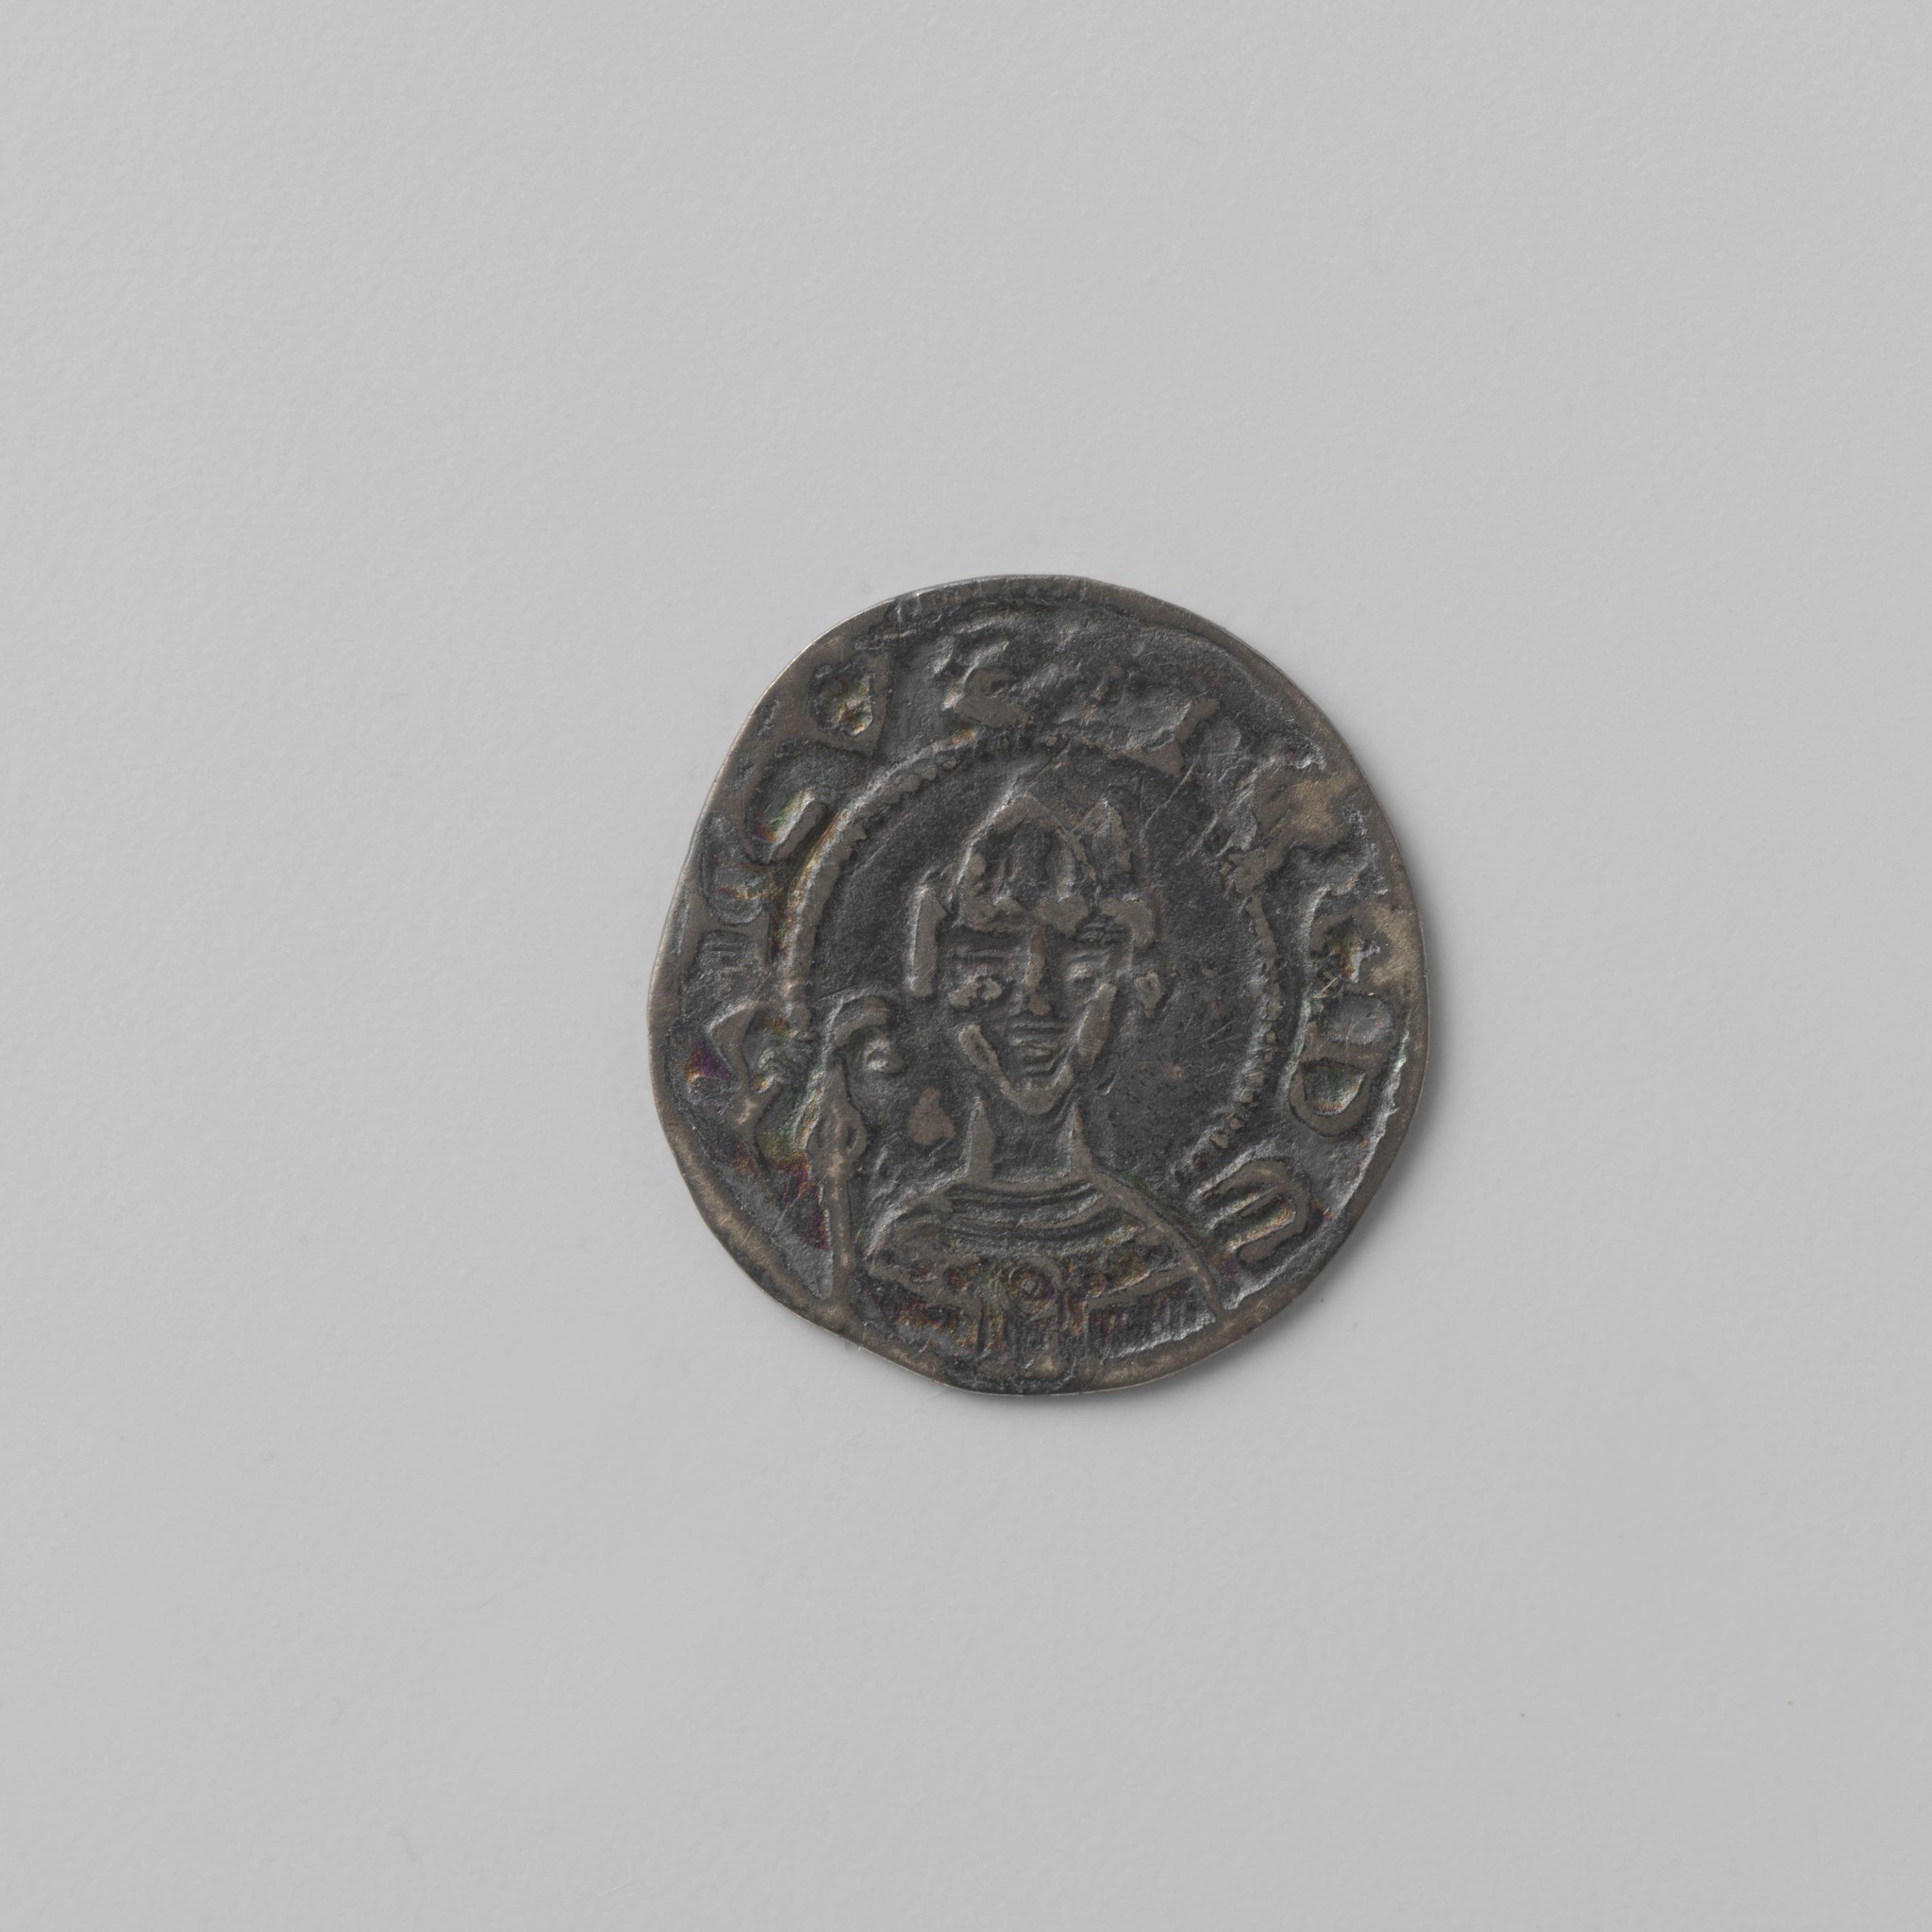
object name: coin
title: Utrecht, Dirk van Ahr, penning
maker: dirk van are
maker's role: bisschop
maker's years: -1212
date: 1198-1212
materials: silver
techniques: striking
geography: utrecht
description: Zilveren munt. Voorzijde: portret van de bisschop van voren met mijter met in rechterhand bisschopsstaf. Omschrift. Keerzijde: kort kruis, in hoeken afwisselend sterretje en drietand. Omschrift.